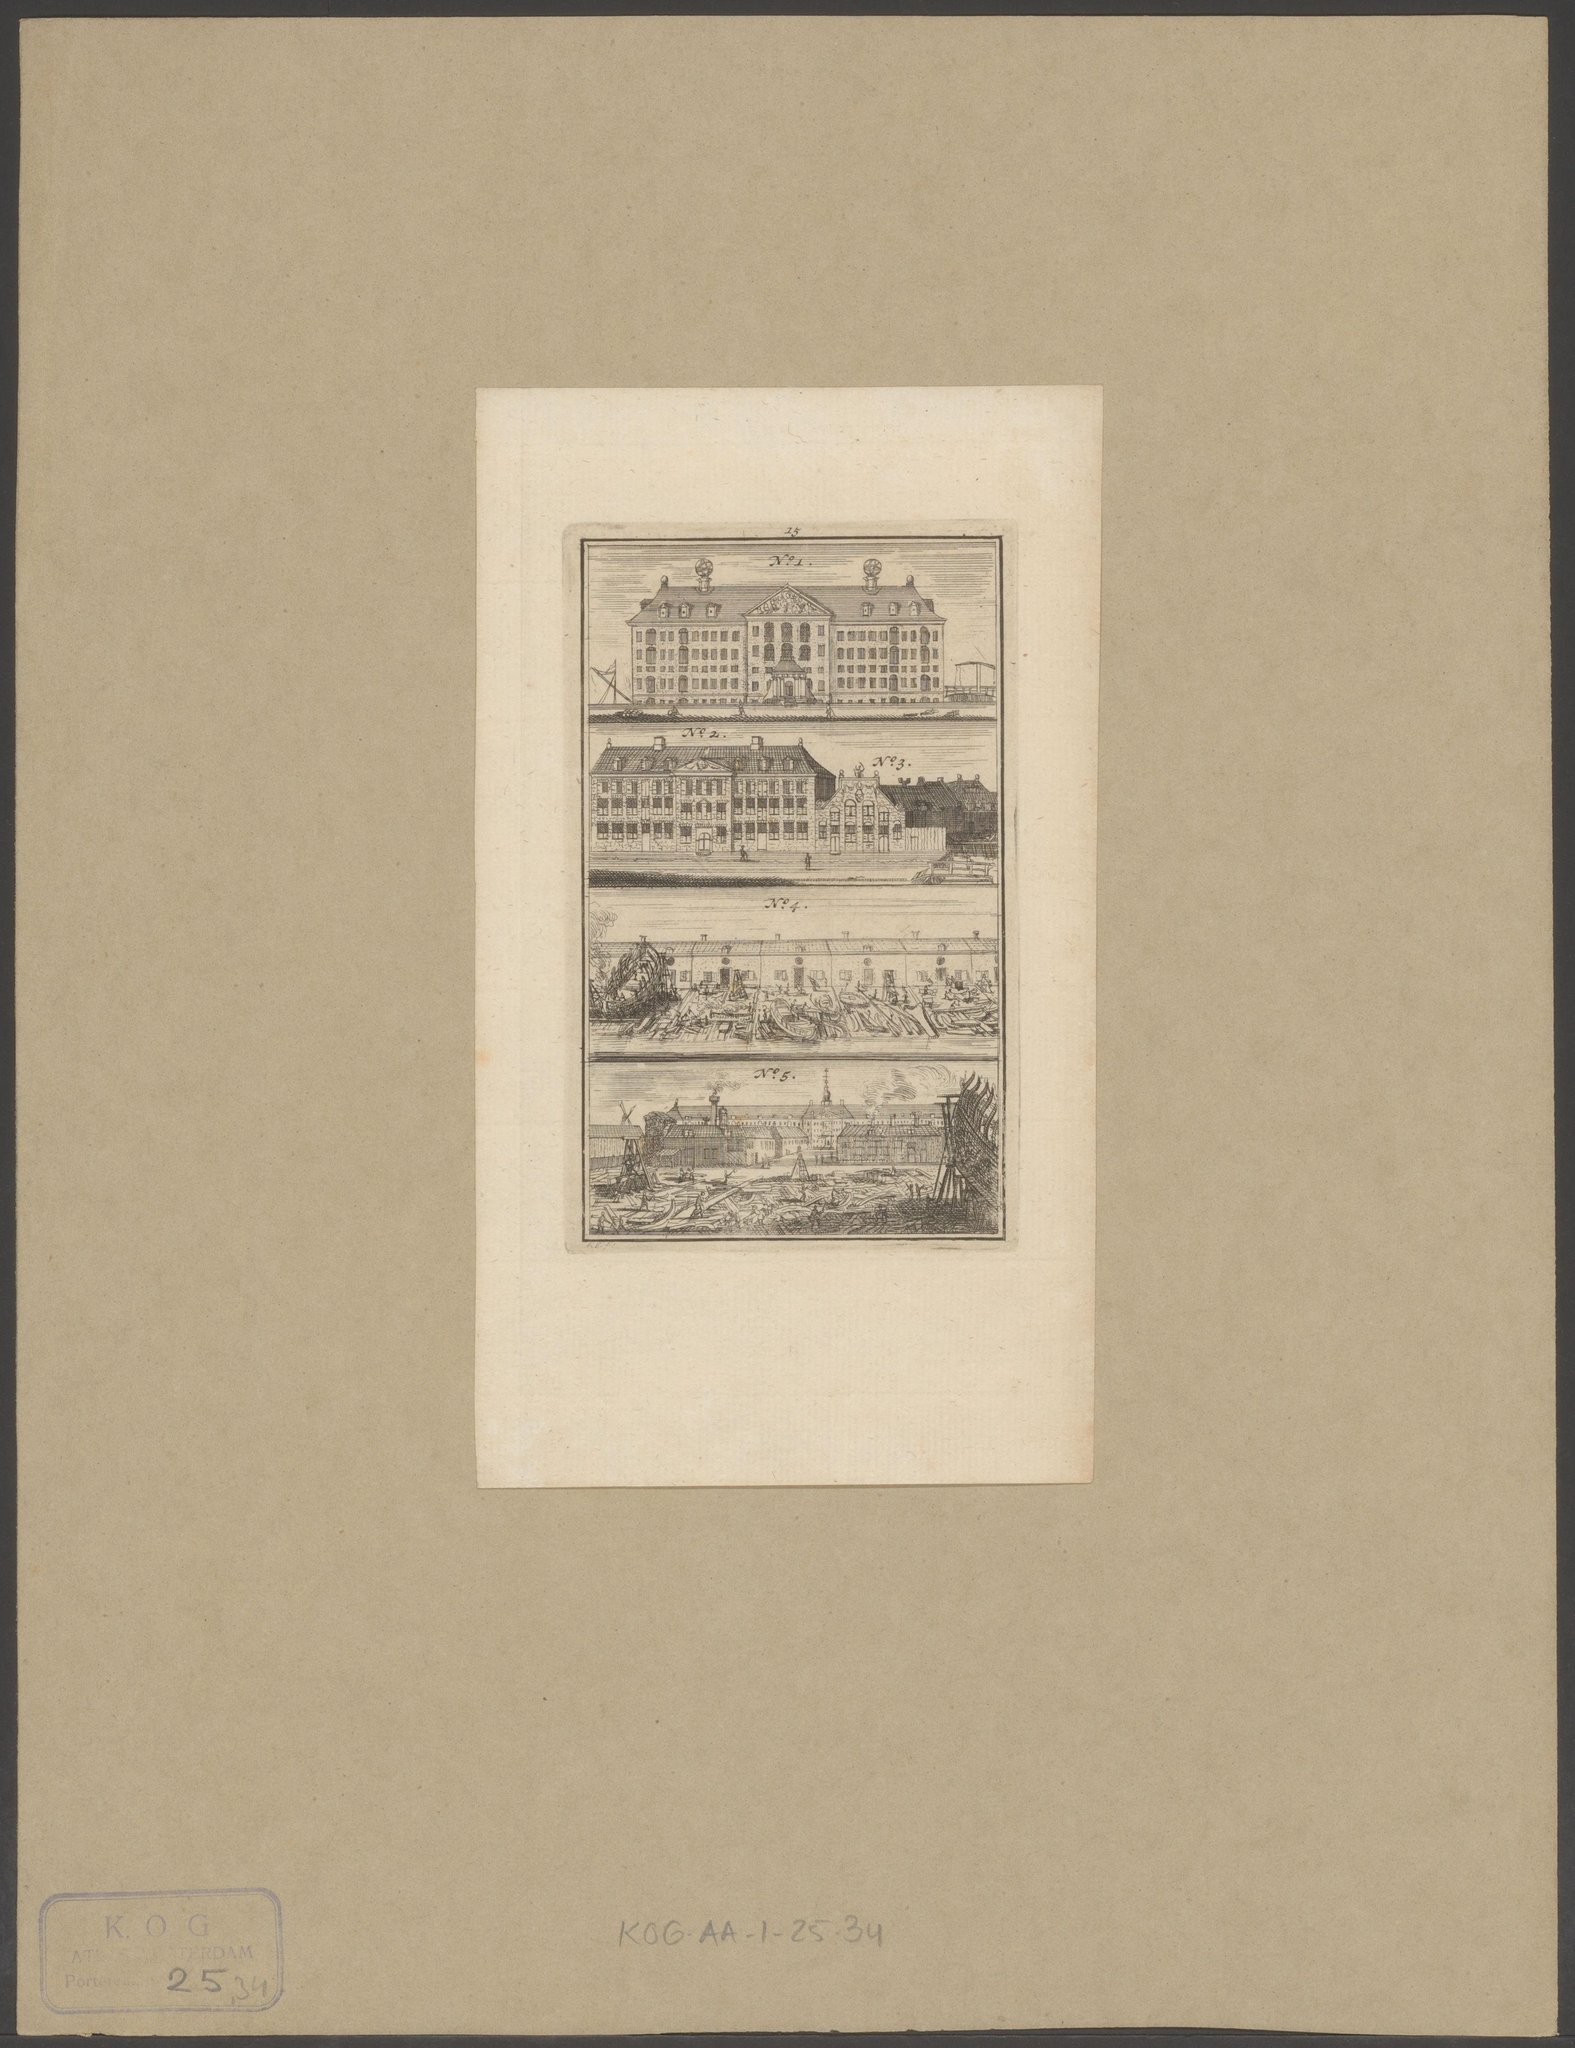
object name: print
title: Verschillende gebouwen en scheepstimmerwerven te Amsterdam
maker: anna folkema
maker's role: draughtsman, print maker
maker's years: 1695-1768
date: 1723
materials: paper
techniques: etching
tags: civic architecture; edifices; dwellings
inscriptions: collector's mark: ‘25.34’ Lugt 1641b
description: Drie gebouwen en twee scheepstimmerwerven te Amsterdam: Admiraliteitsmagazijn, Lijnbaan van de VOC, Lijnbaan van de Admiraliteit, Scheepswerfterrein van de VOC. Boven genummerd: 15. Onderwerpsrubriek binnen de Atlas Amsterdam: Krijgswezen I: De Admiraliteit van Amsterdam, A. Admiraliteitsgebouwen.